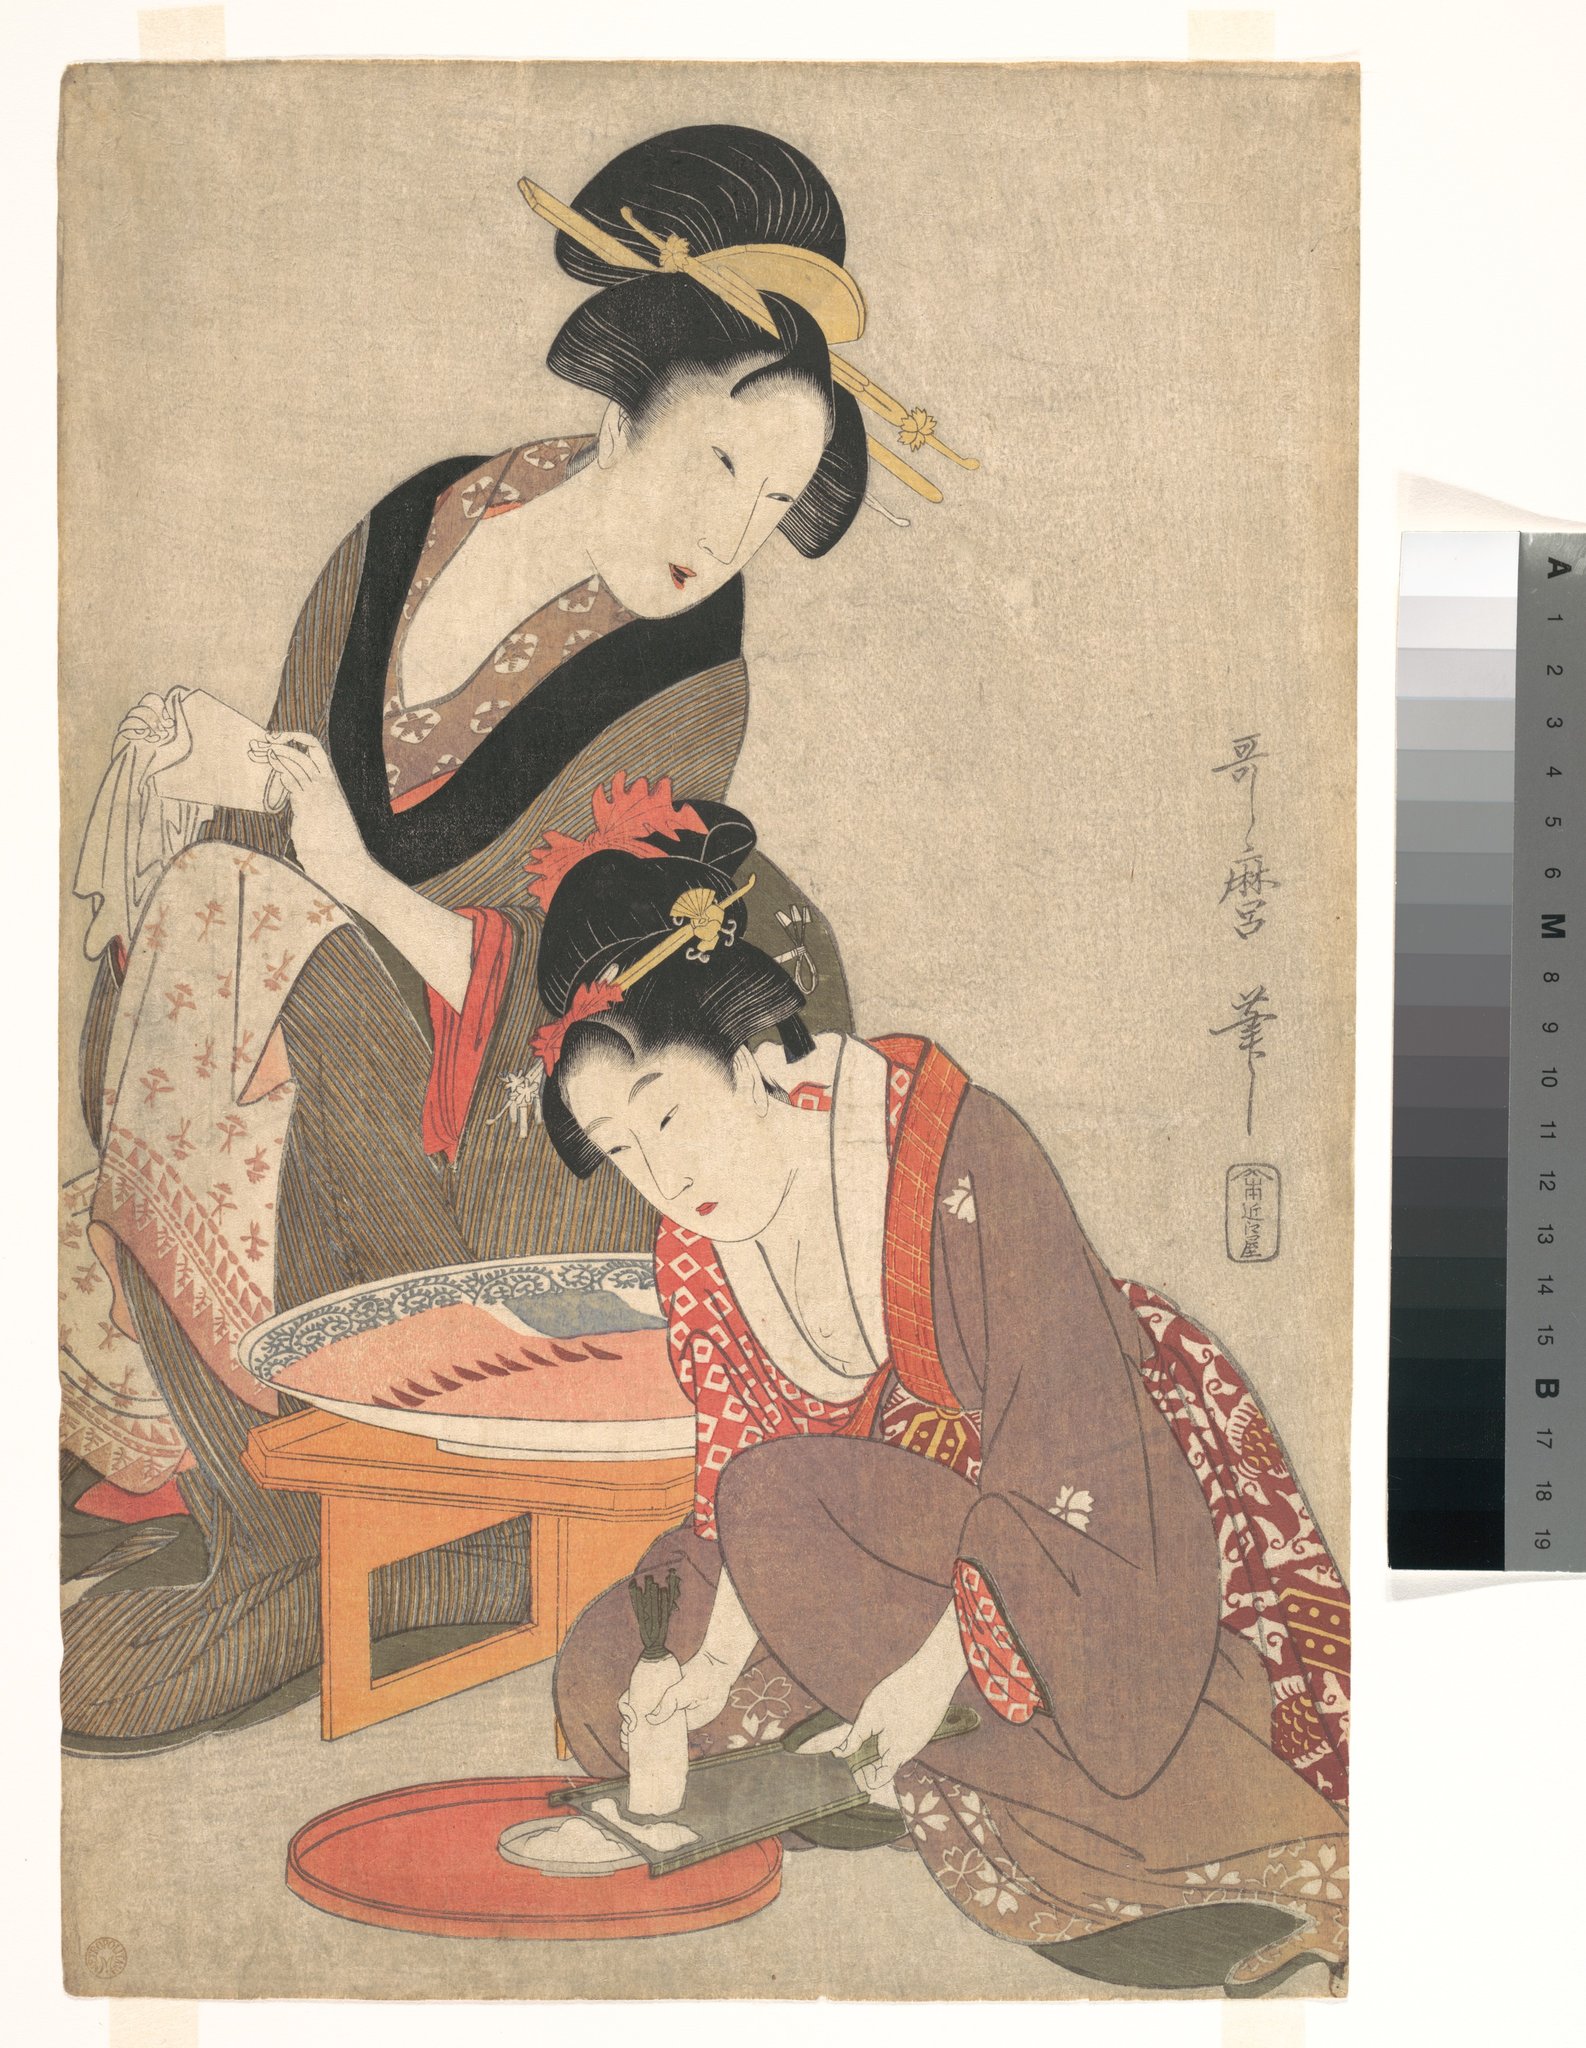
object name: print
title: Women Preparing Sashimi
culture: japanese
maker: kitagawa utamaro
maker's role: artist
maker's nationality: japanese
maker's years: 1754-1806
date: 1806-1820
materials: ink, paper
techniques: woodblock print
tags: food,women